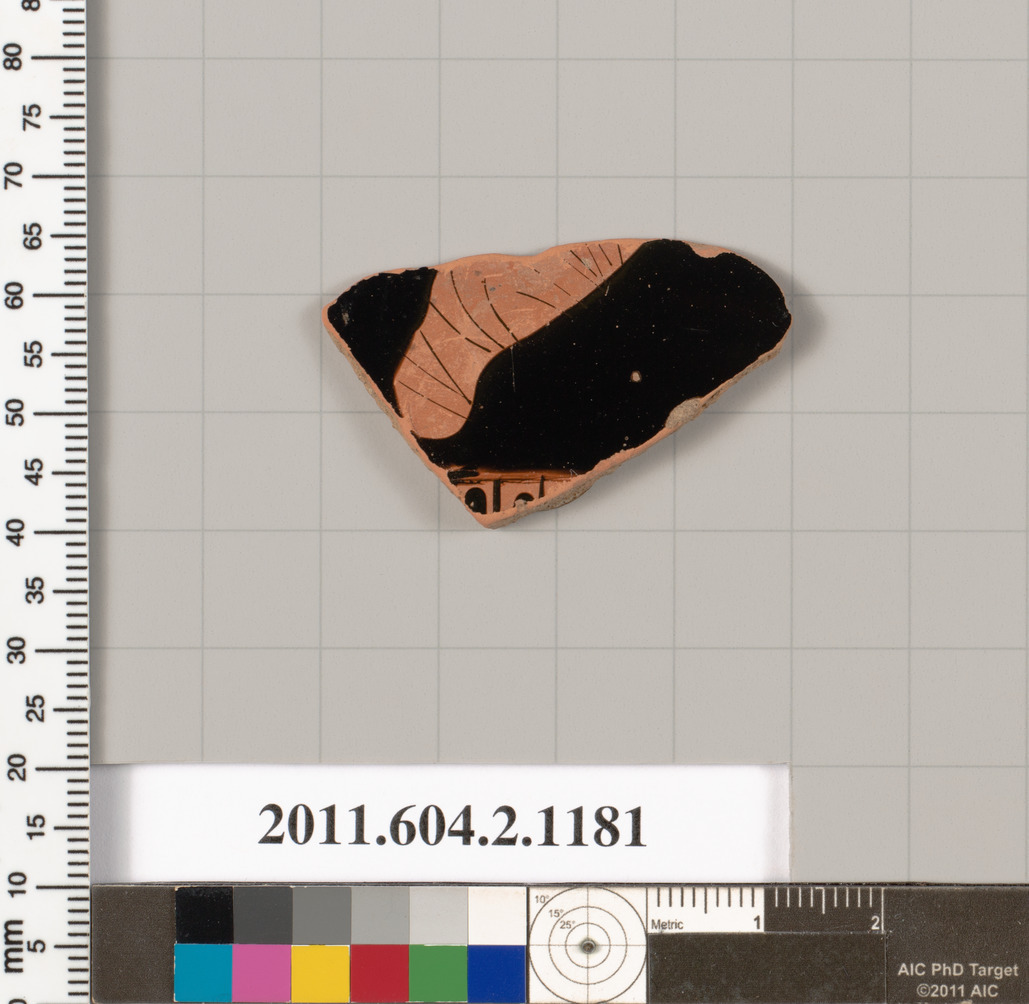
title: Terracotta fragment of a small, closed shape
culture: greek, attic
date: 450-426 BCE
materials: terracotta